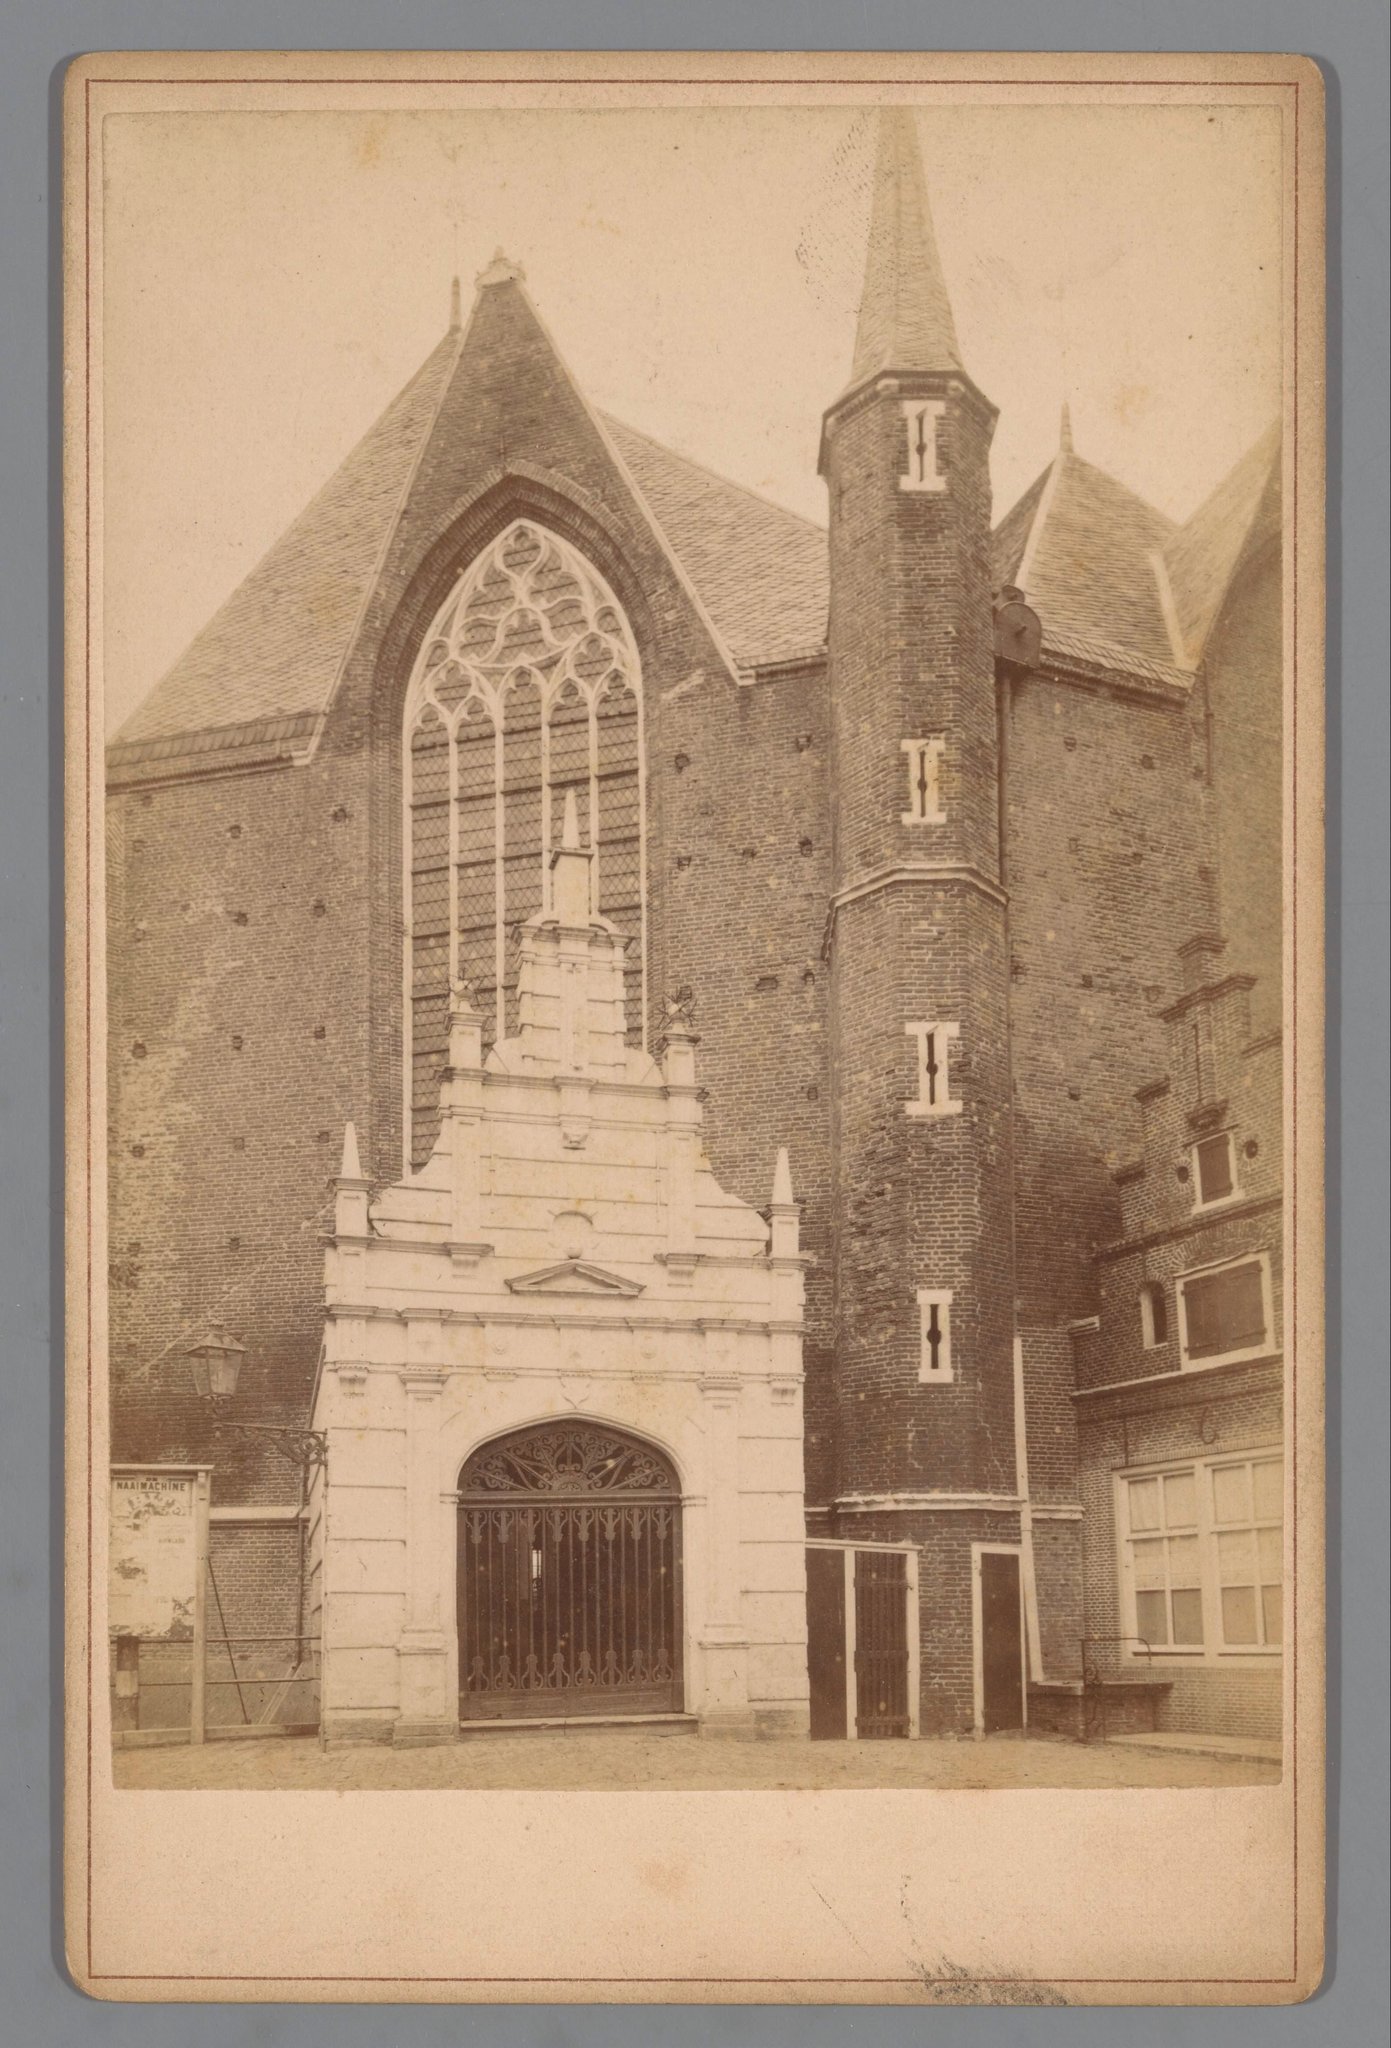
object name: photograph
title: Gezicht op de oostzijde van de Westerkerk in Enkhuizen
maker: Anonymous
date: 1850-1900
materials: cardboard, photographic support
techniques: albumen print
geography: enkhuizen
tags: church (exterior)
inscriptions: annotation: ‘Enkhuizen’, annotation: ‘Westerkerk. Enk[...]’